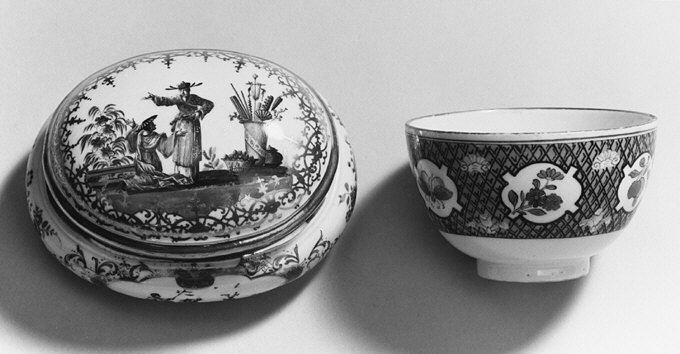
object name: bowl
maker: meissen manufactory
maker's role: manufactory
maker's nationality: german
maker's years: 1710-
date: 1740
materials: hard paste porcelain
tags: men,women,trees